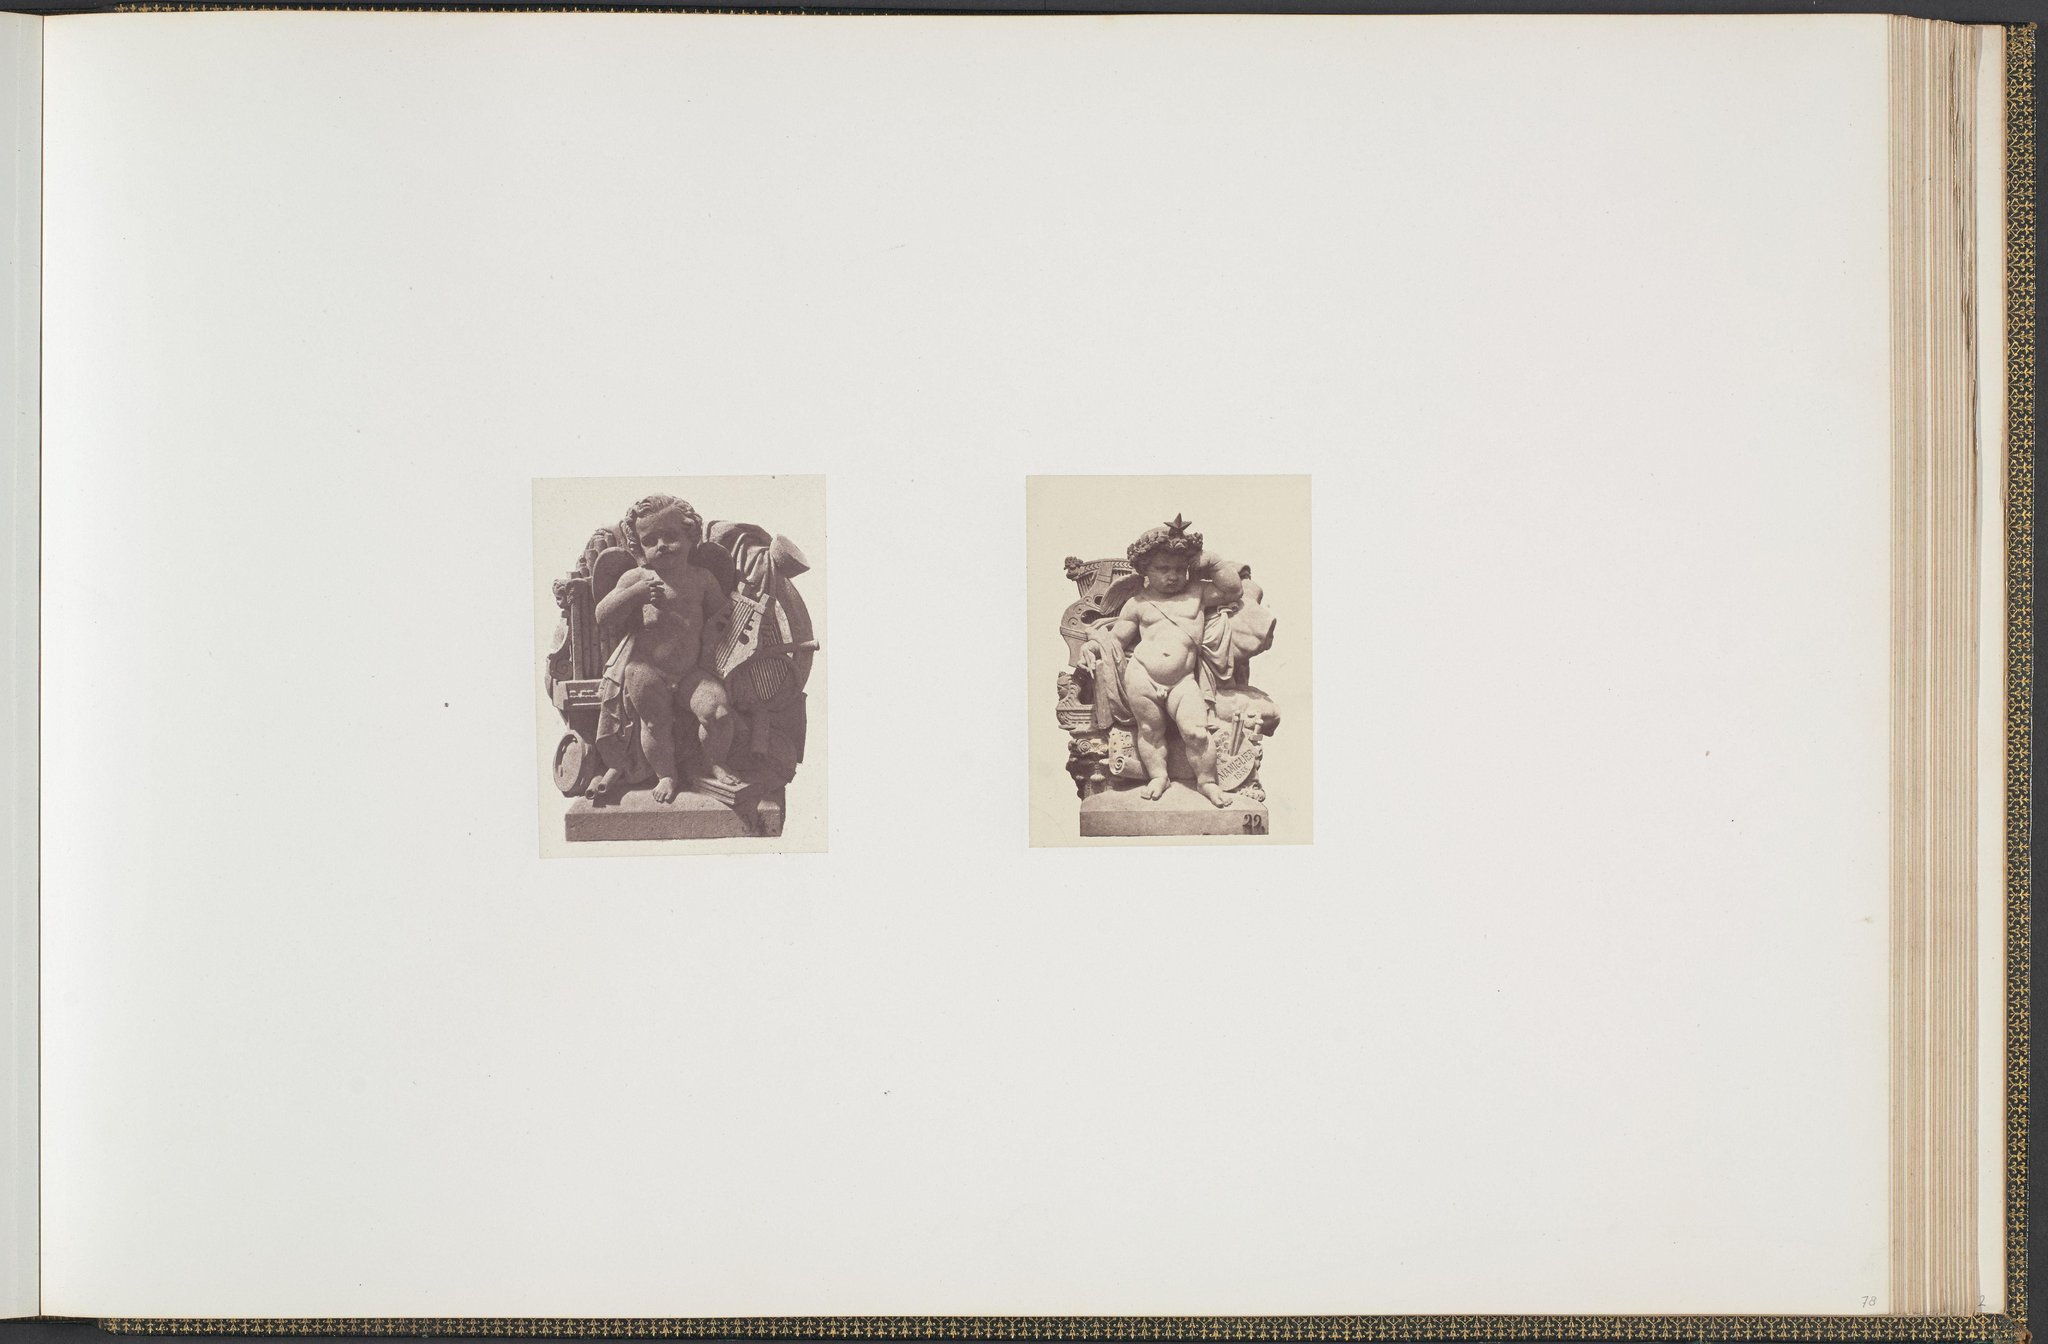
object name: photograph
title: Gipsmodellen voor beeldhouwwerken op het Palais du Louvre: links "La Musique" door Elias Robert en rechts "Les Beaux-Arts" door Henri-Charles Maniglier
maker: édouard denis baldus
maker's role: fotograaf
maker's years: 1813-1889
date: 1855-1857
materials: paper, photographic support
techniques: salted paper print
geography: paris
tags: piece of sculpture, reproduction of a piece of sculpture, permanent exhibition, museum, paris, tuileries palace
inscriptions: number: ‘34 en 22’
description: Onderdeel van Réunion des Tuileries au Louvre 1852-1857, album 2.